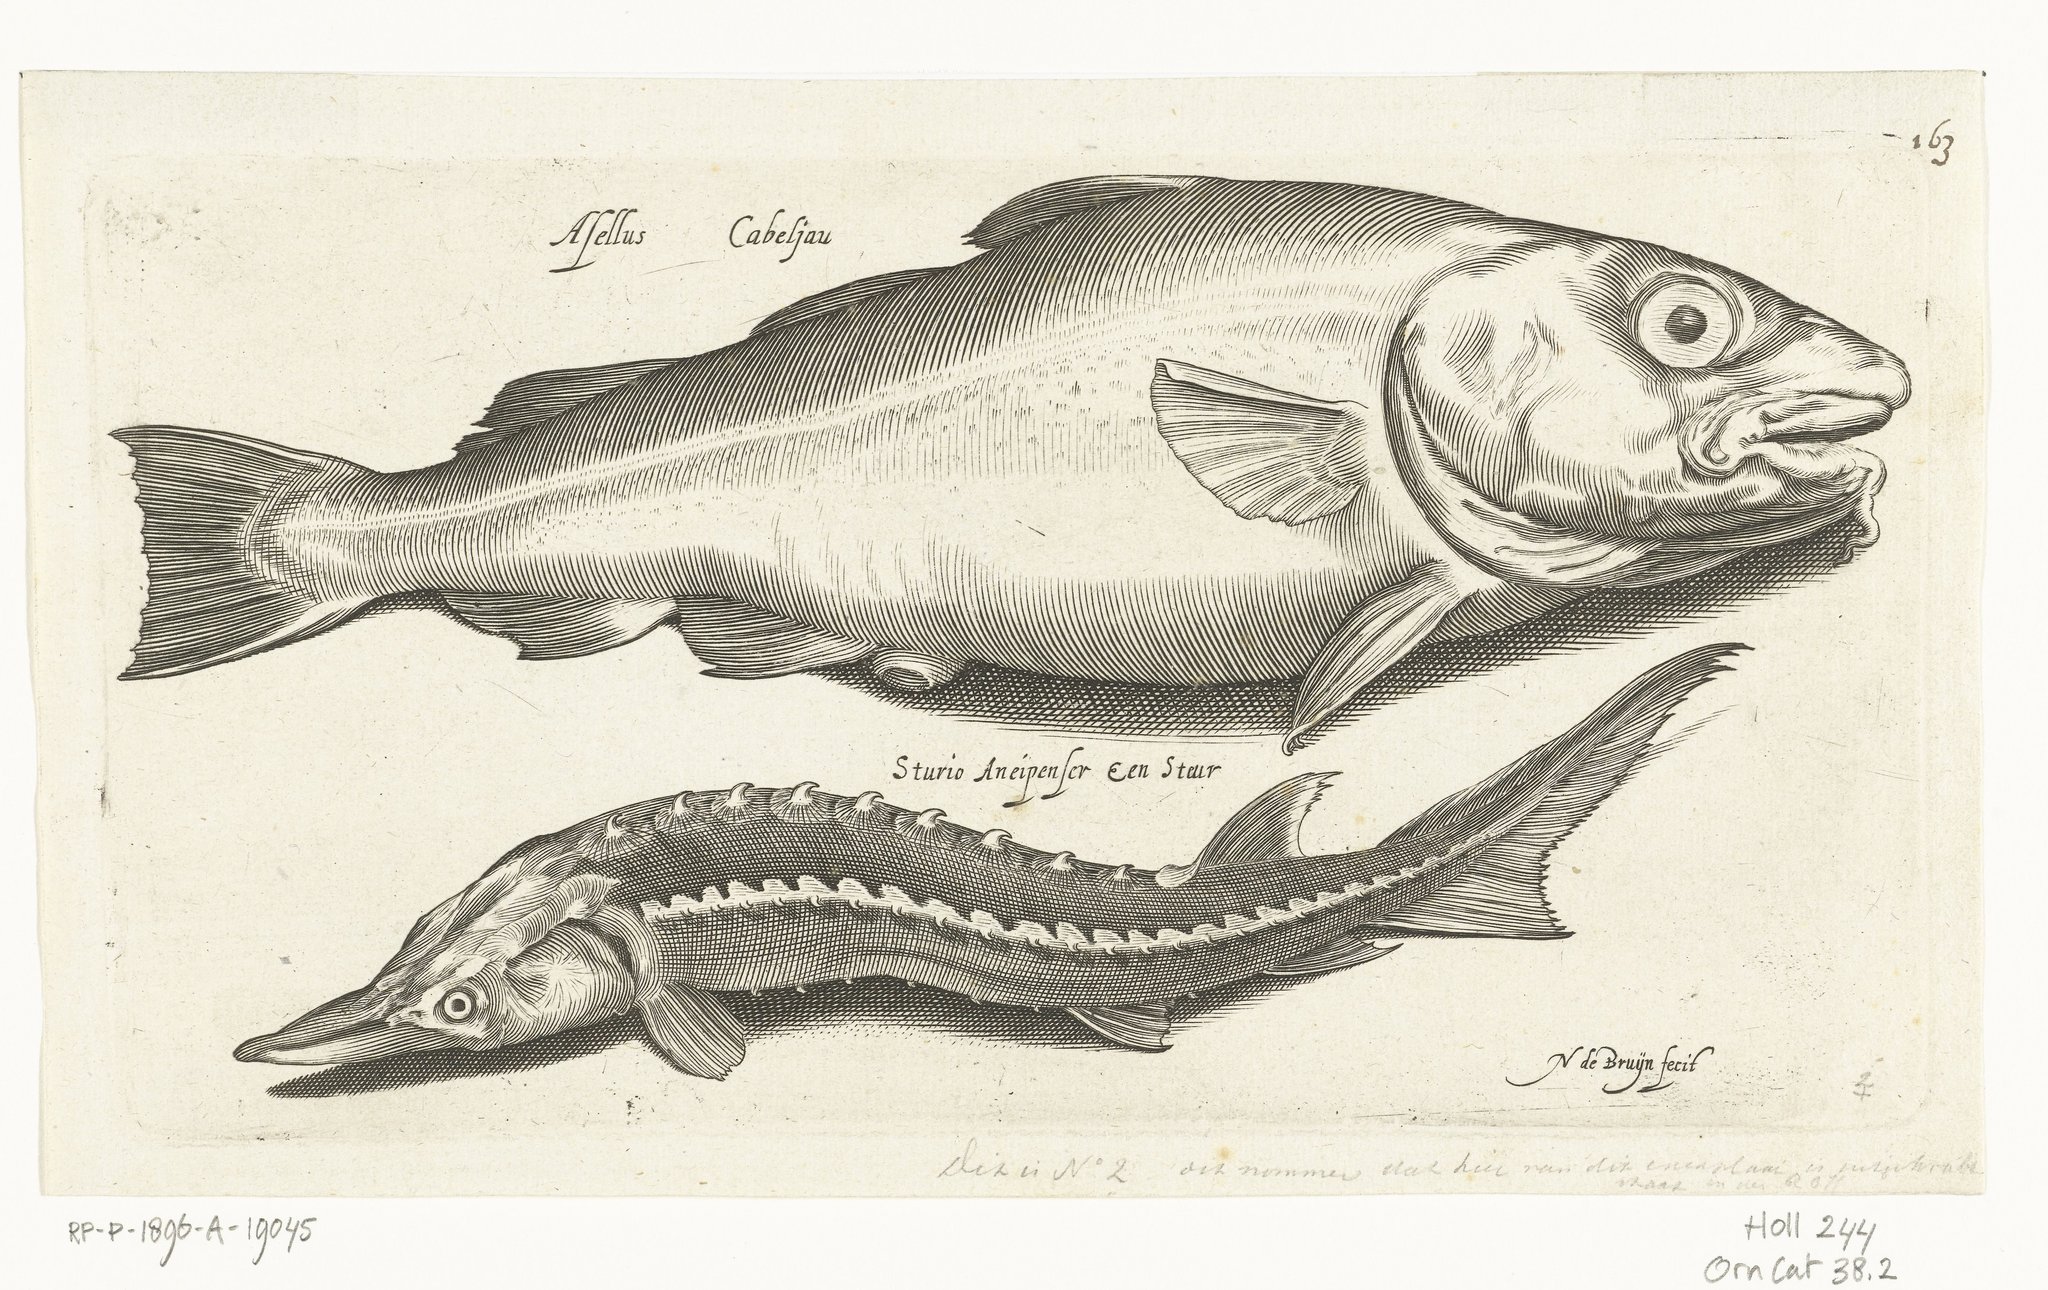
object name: print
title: Zoetwatervissen, zeevissen, kikkers, schaaldieren en zeewezens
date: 1581-1656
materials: paper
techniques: engraving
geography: netherlands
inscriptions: collector's mark: Lugt 2228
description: Prent uit serie Libelivs varia Genera piscium complectens van dertien prenten met zoetwatervissen, zeevissen, kikkers, schaaldieren en zeewezens (inclusief titelprent). Het nummer 2 op het blad is weggekrabt en later met potlood handgeschreven toegevoegd.